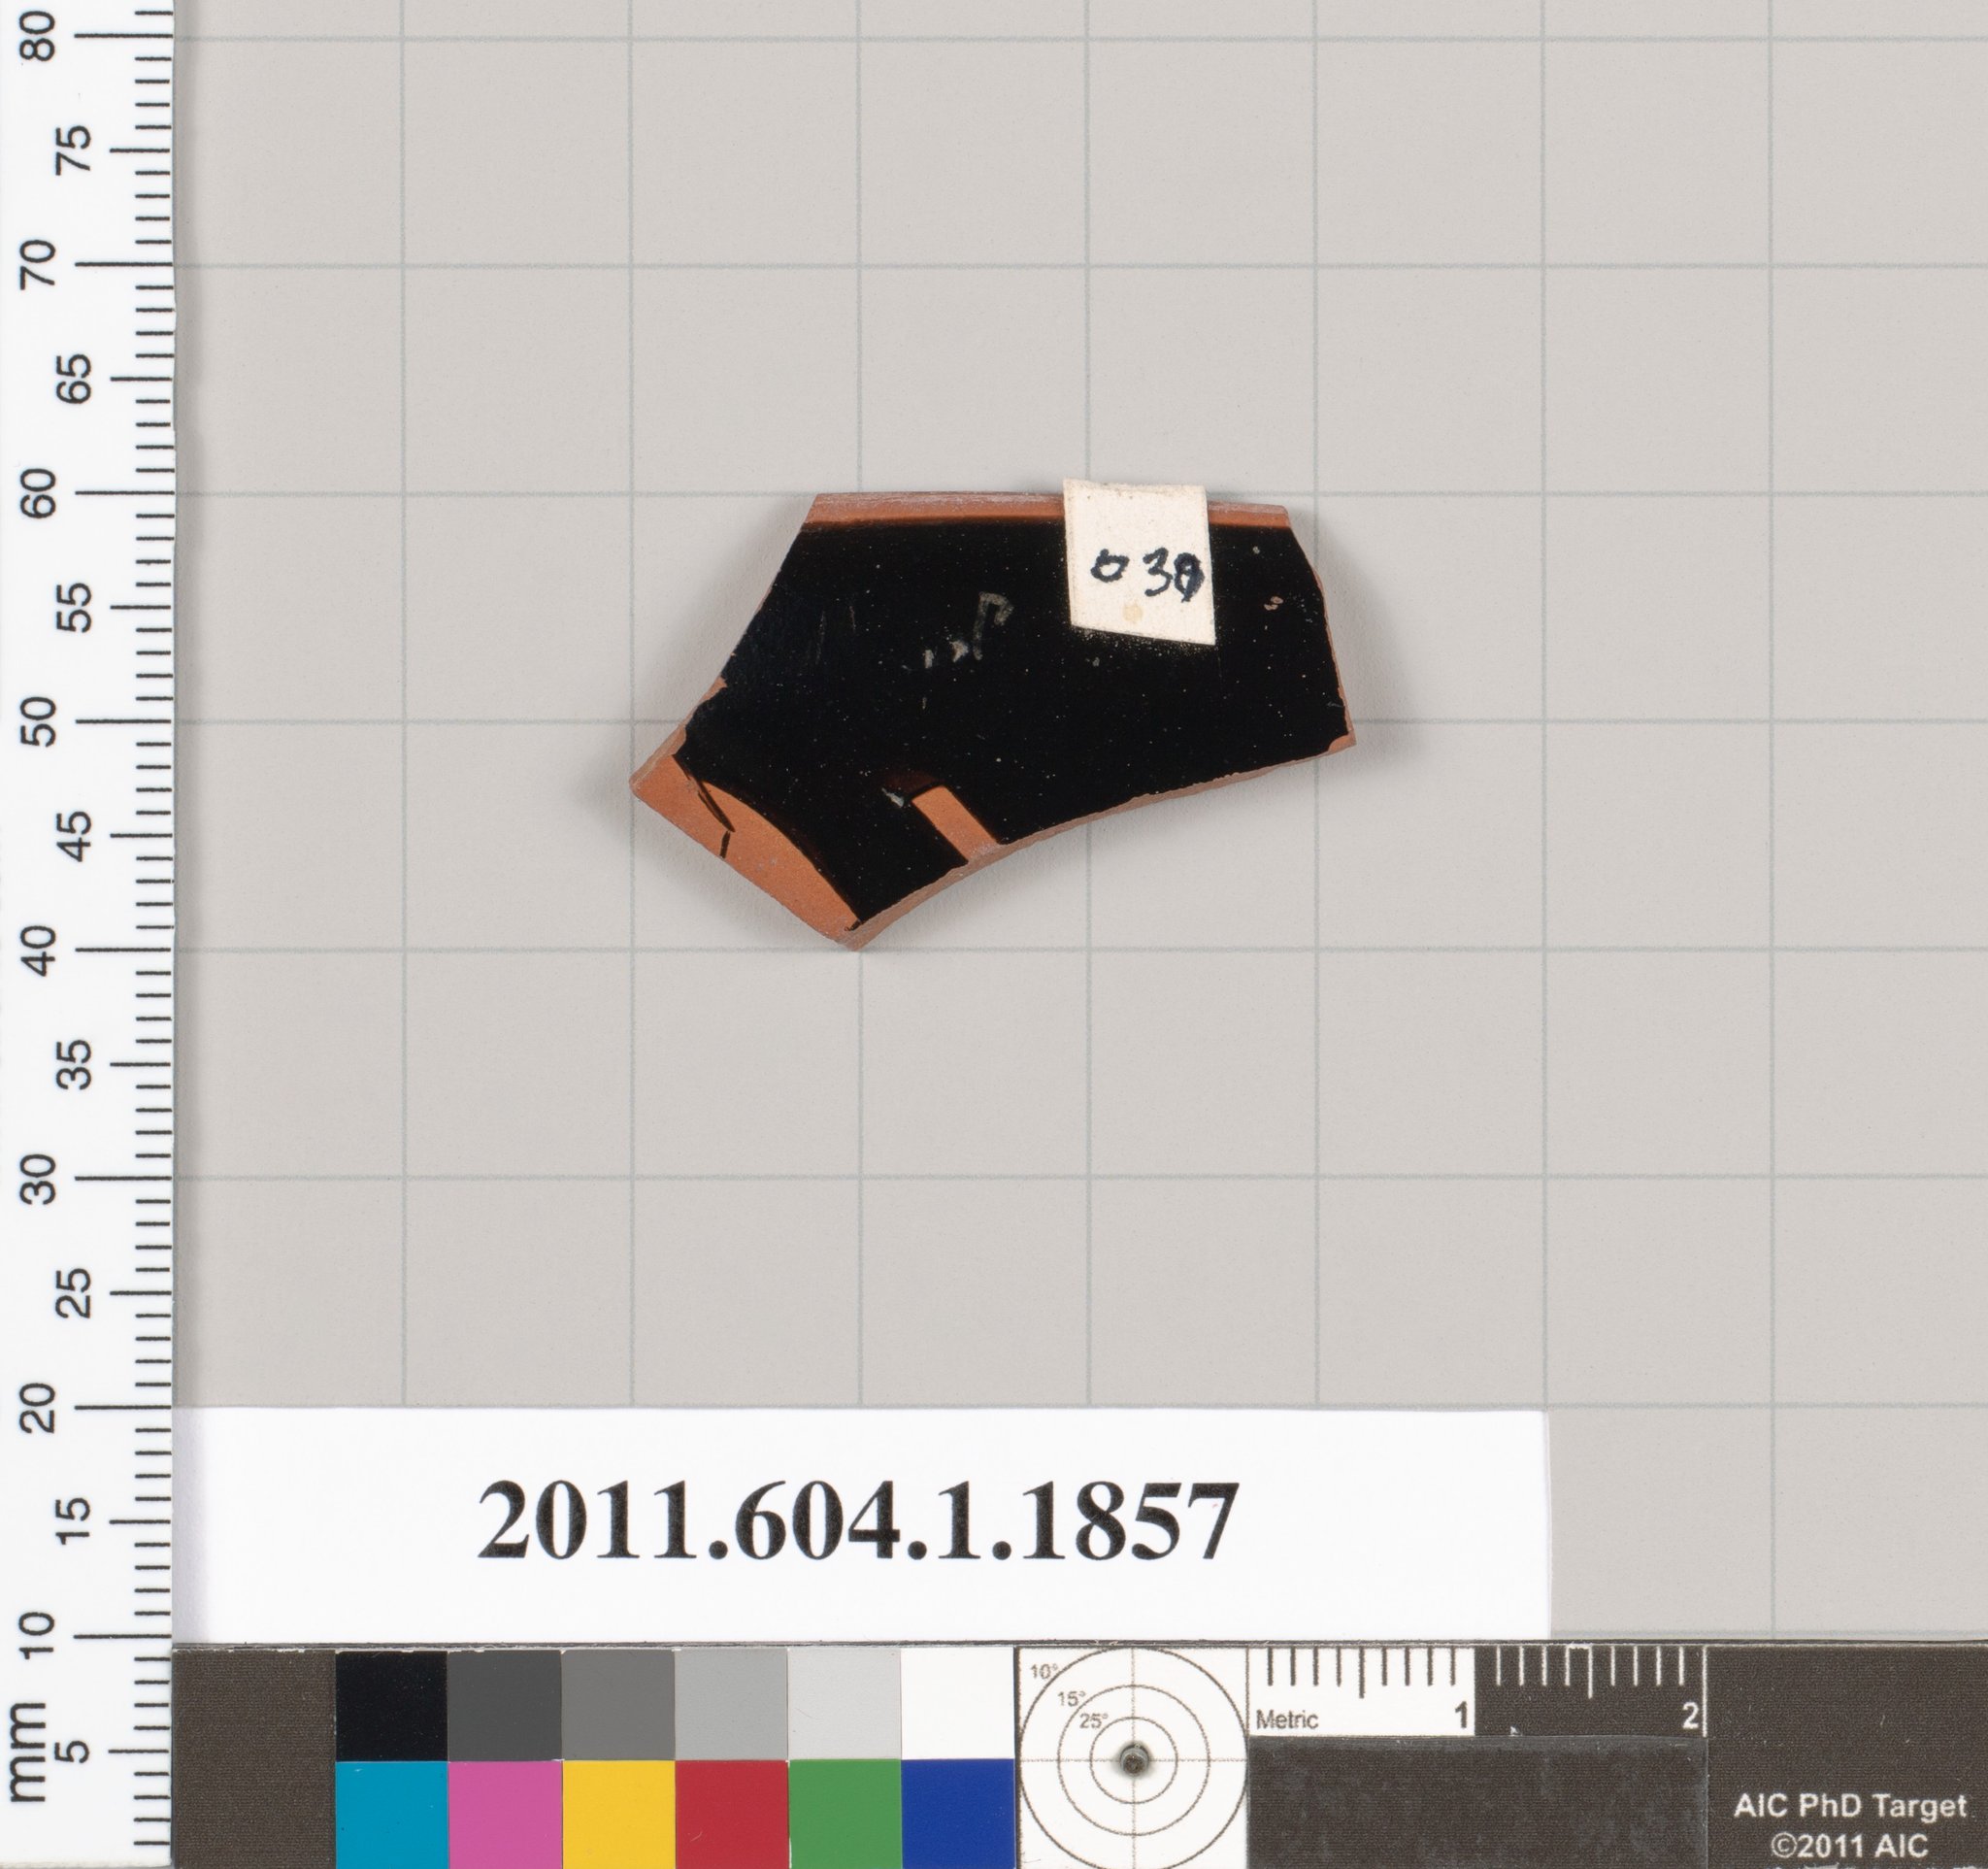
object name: kylix fragment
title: Terracotta rim fragment of a kylix (drinking cup)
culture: greek, attic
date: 475-451 BCE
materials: terracotta